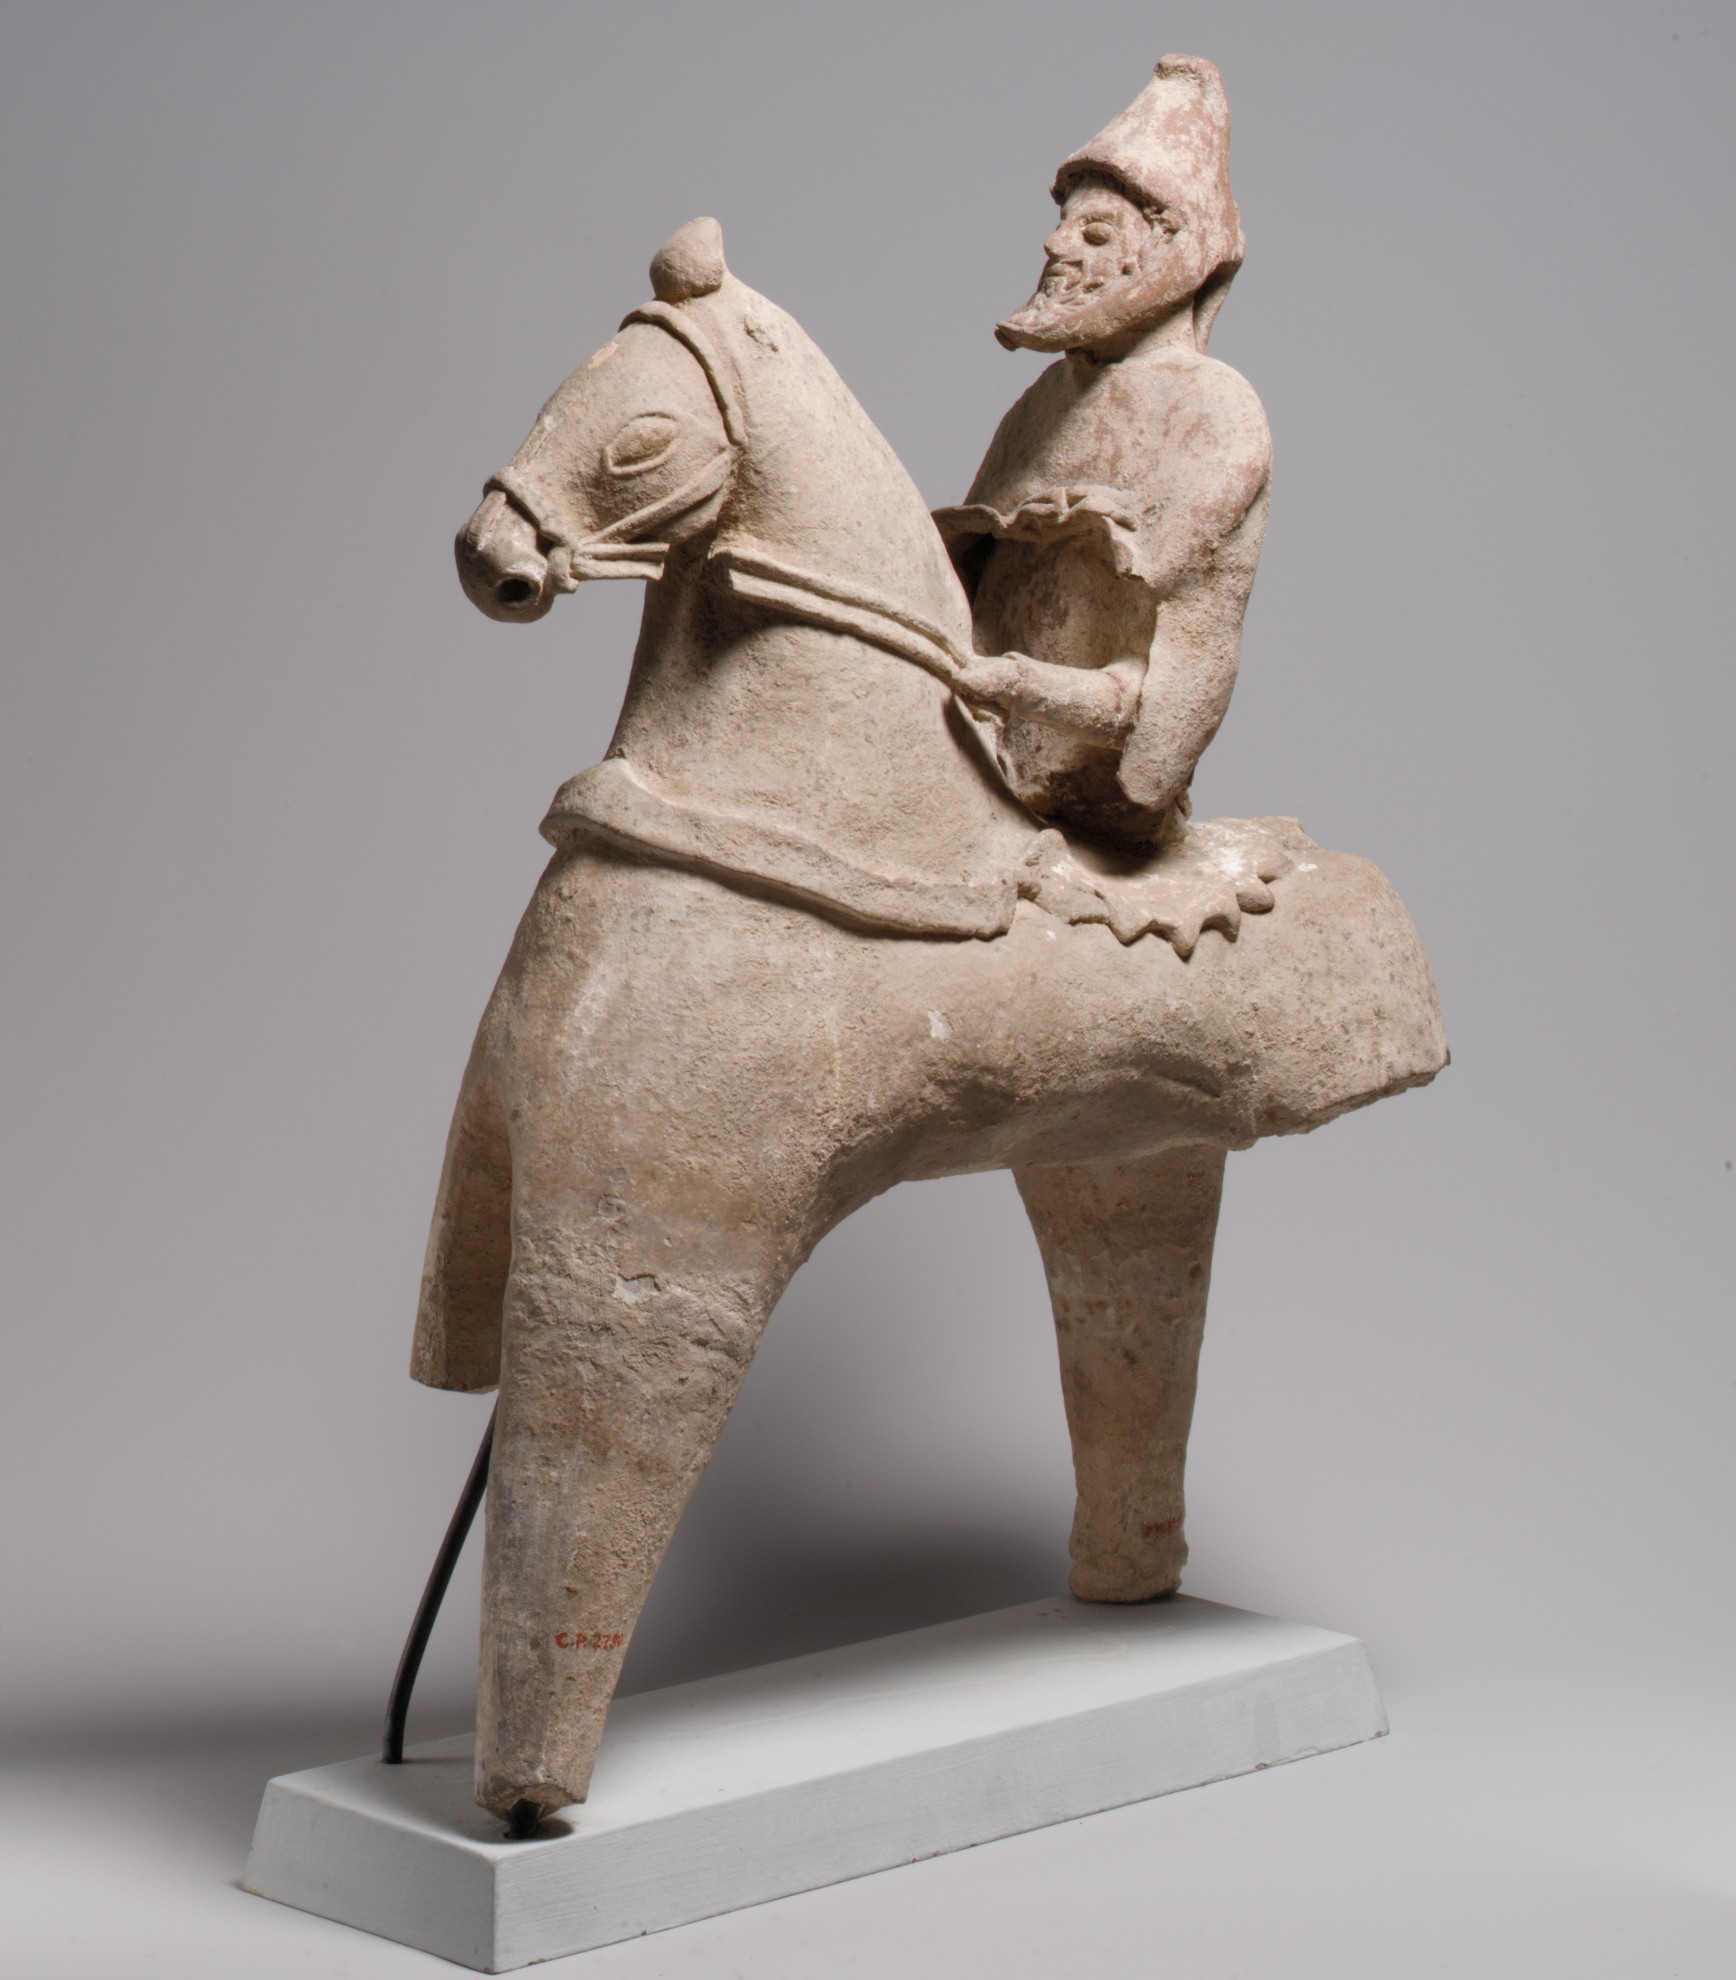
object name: statue of a horseman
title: Terracotta statuette of a horse and rider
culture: cypriot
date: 500-301 BCE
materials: terracotta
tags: men,horses